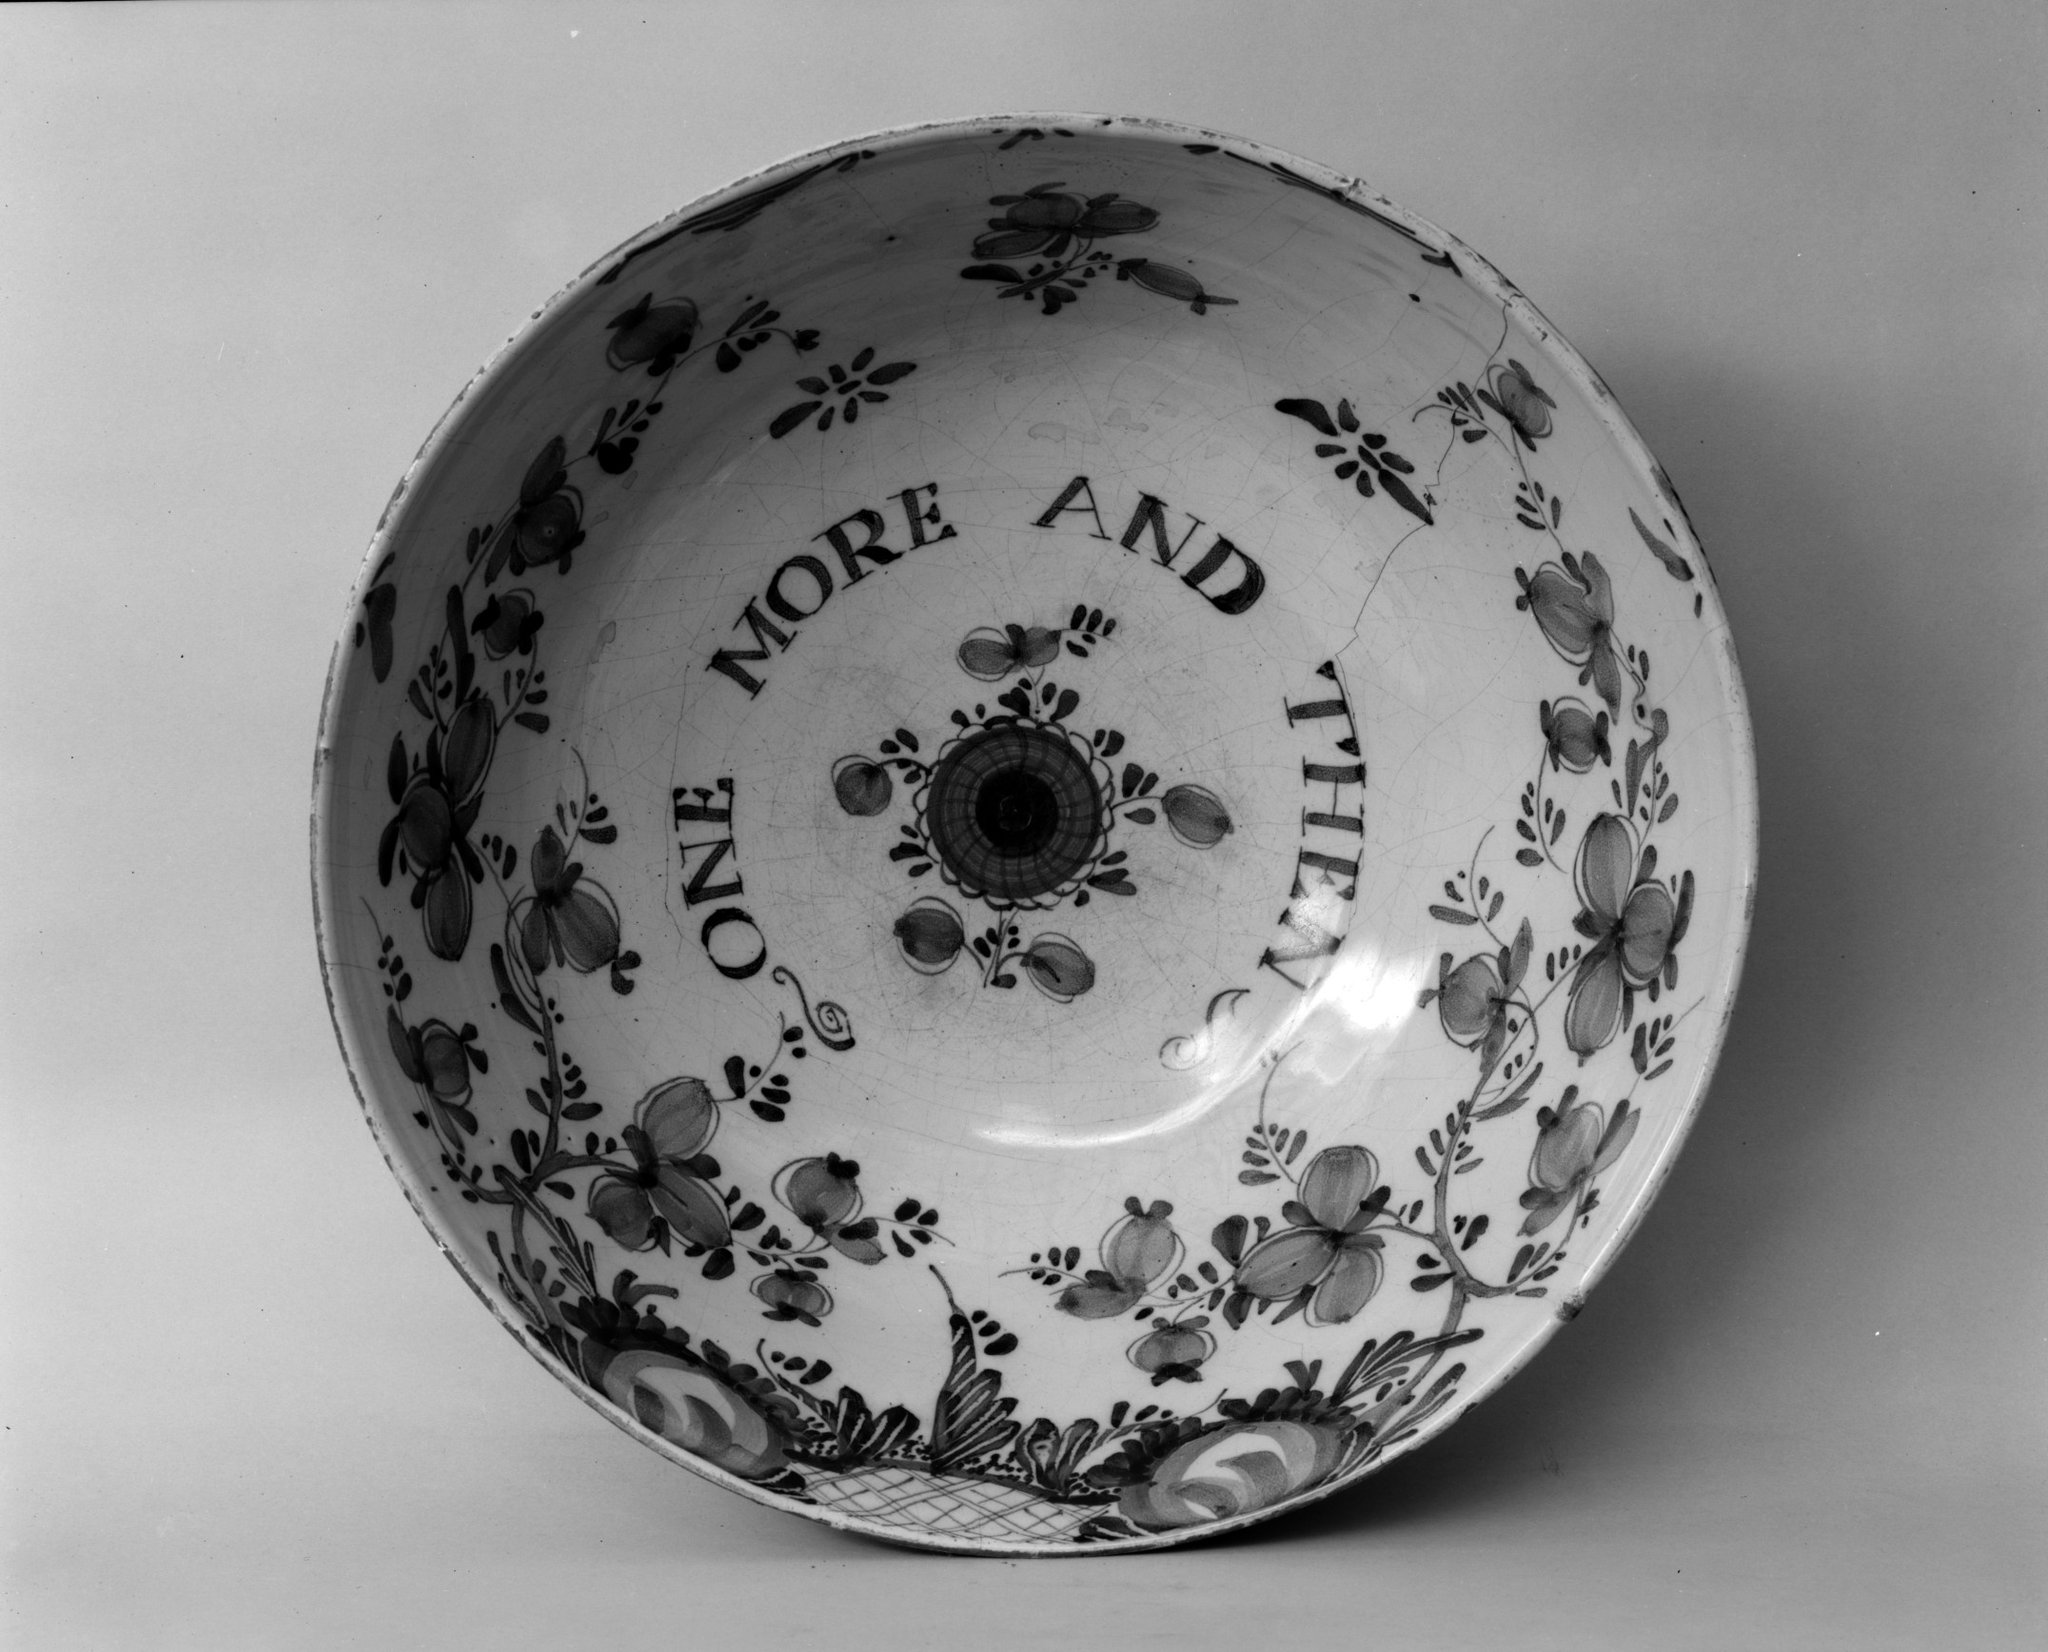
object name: bowl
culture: british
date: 1760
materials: earthenware, tin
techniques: enamel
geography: england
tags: flowers